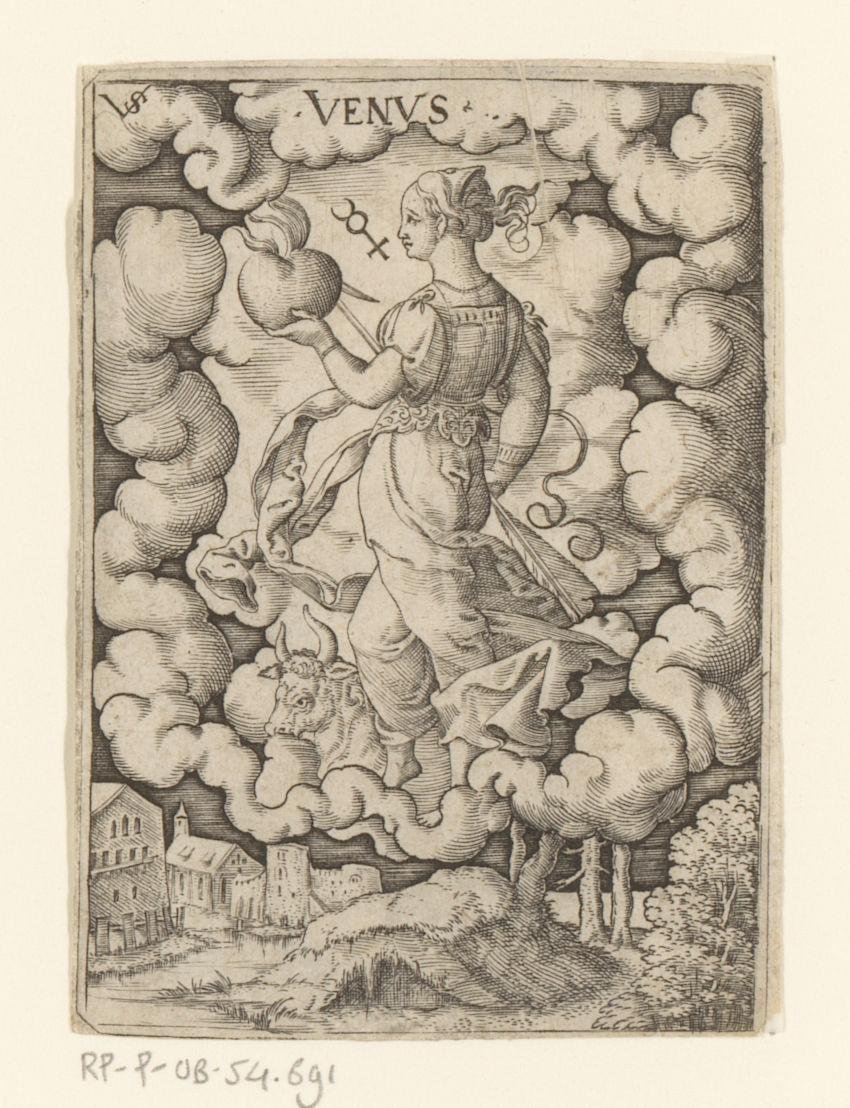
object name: print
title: Personificaties van de zeven planeten omringd door wolken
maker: virgilius solis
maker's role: draughtsman, print maker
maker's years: 1514-1562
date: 1524-1562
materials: paper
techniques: engraving, etching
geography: nuremberg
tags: clouds, (story of) venus (aphrodite), venus (planet)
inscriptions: collector's mark: Lugt 2228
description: Maakt deel uit van een serie die bestaat uit zeven prenten met personificaties van planeten omringd door wolken. Op verso een licht afzetsel van een andere prent.